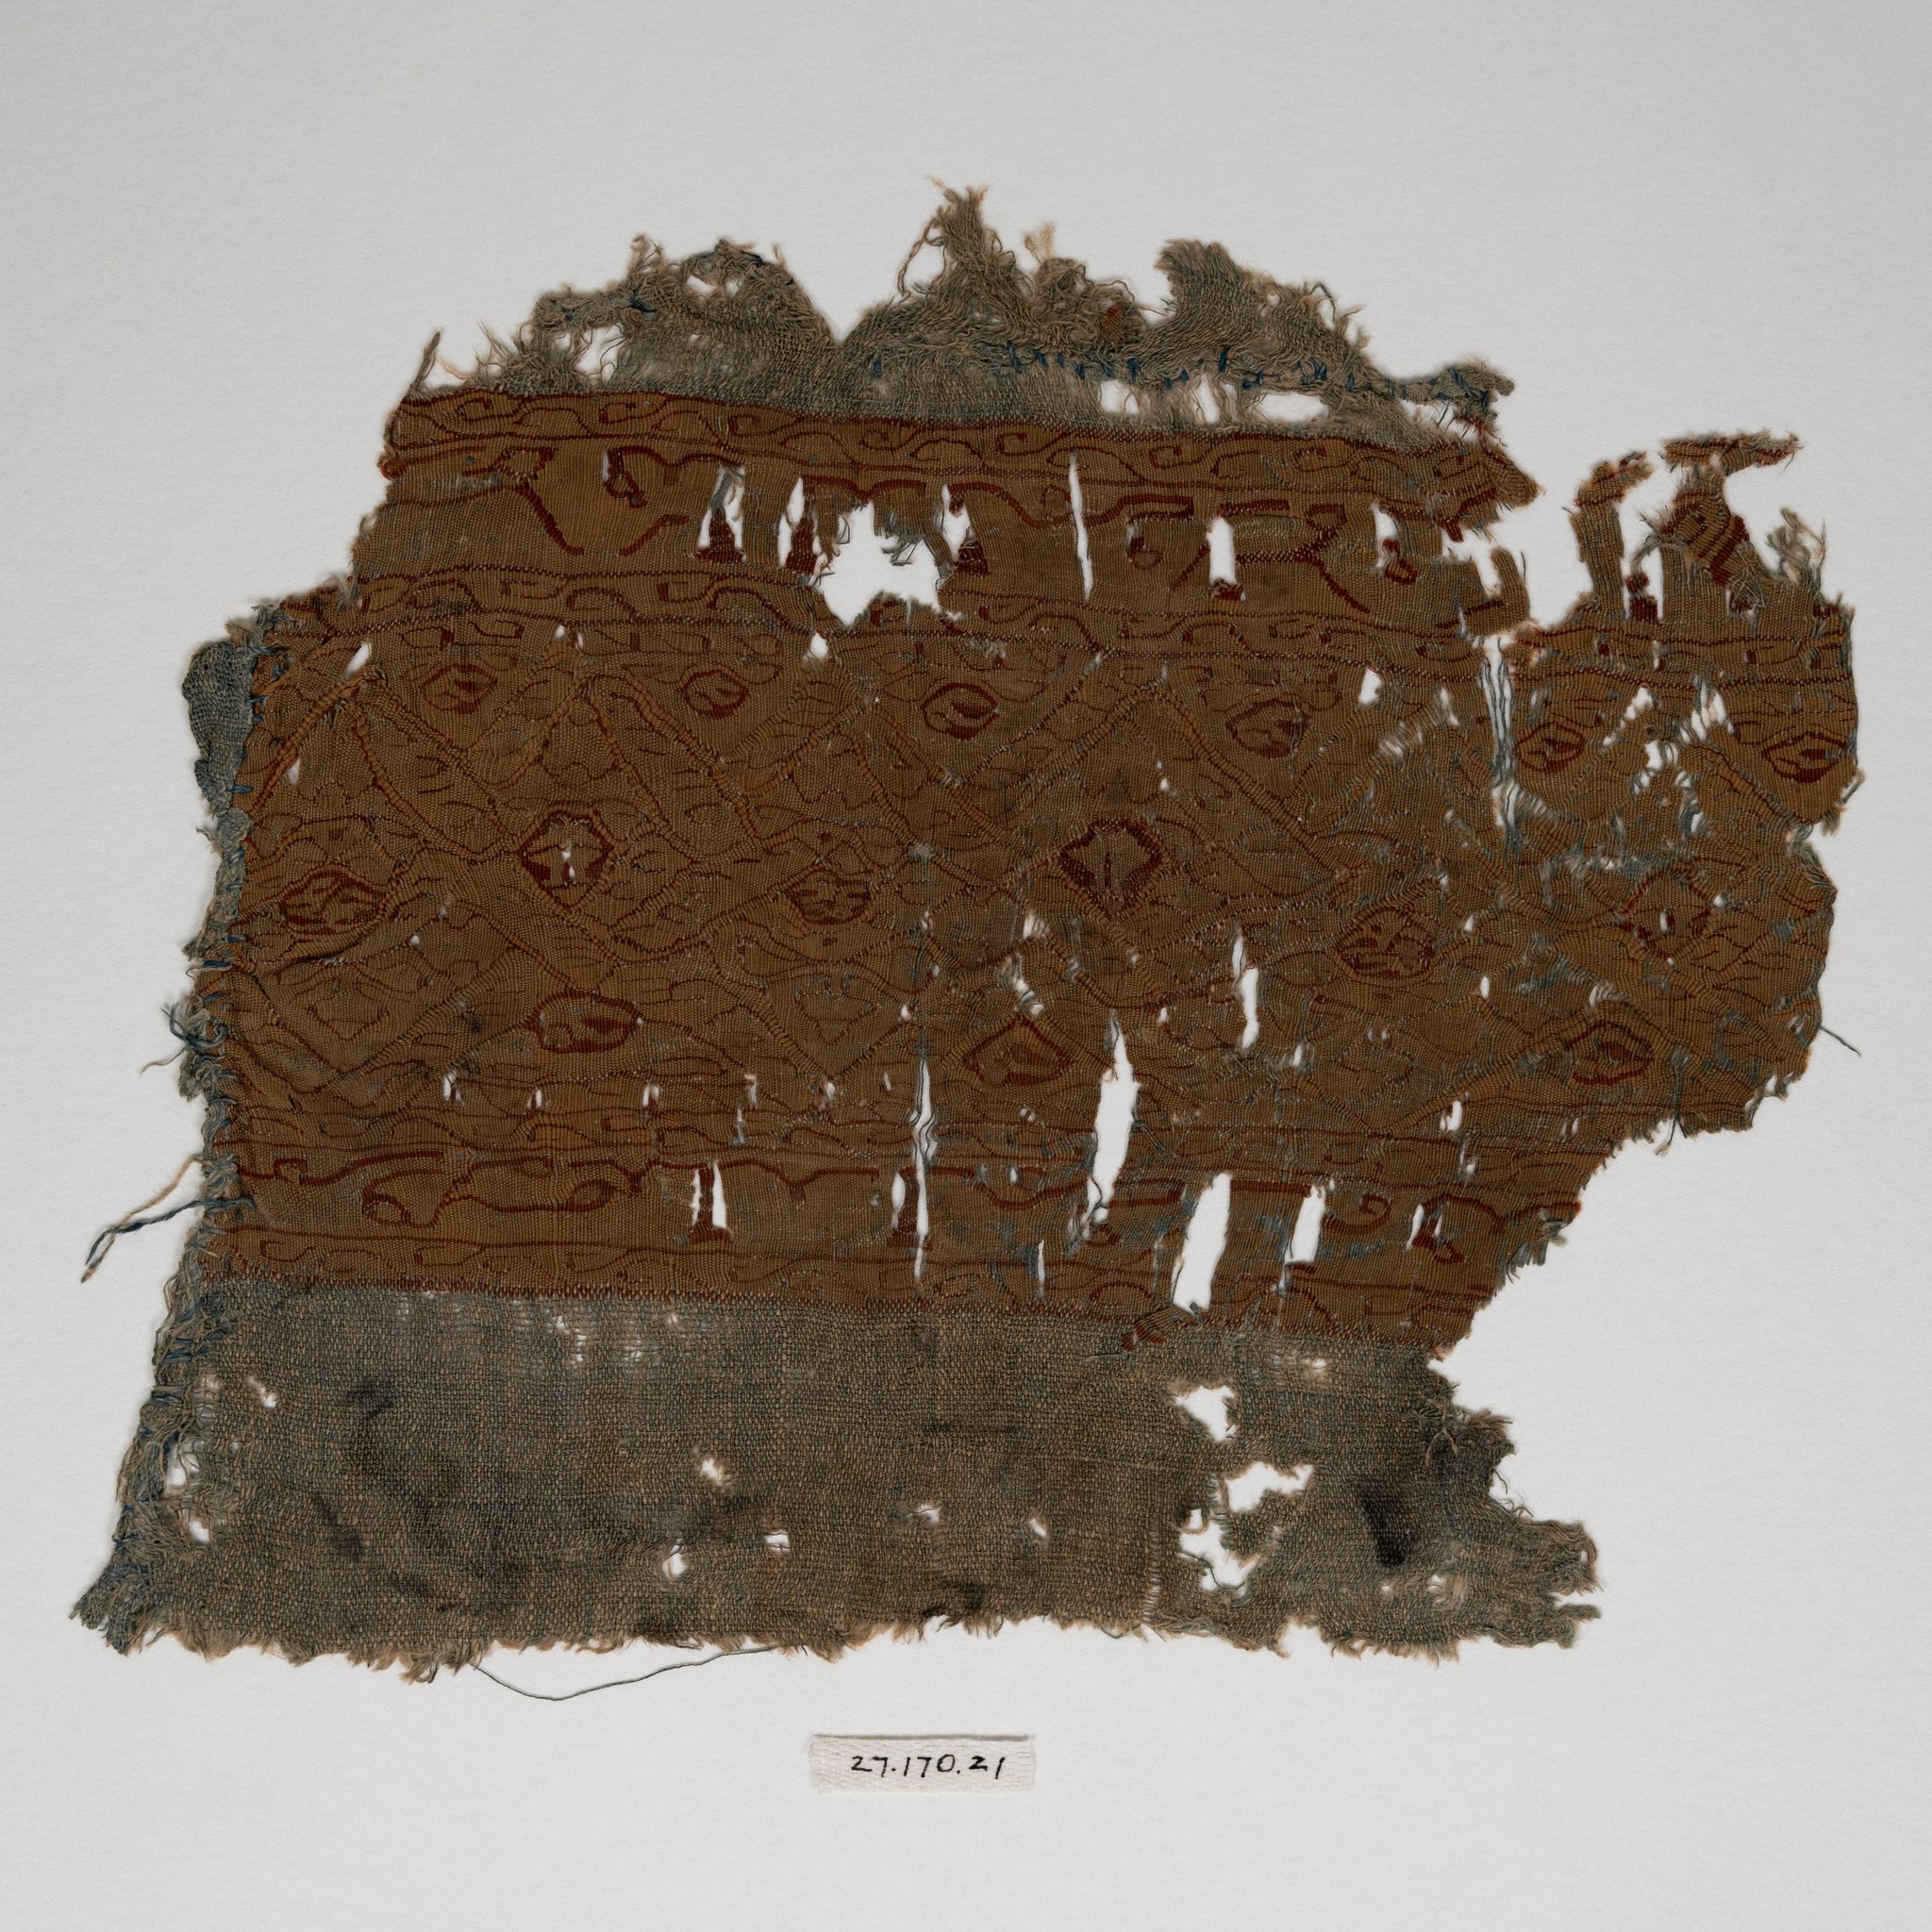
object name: textile fragment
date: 1101-1200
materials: cotton, silk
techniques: tapestry, weave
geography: egypt